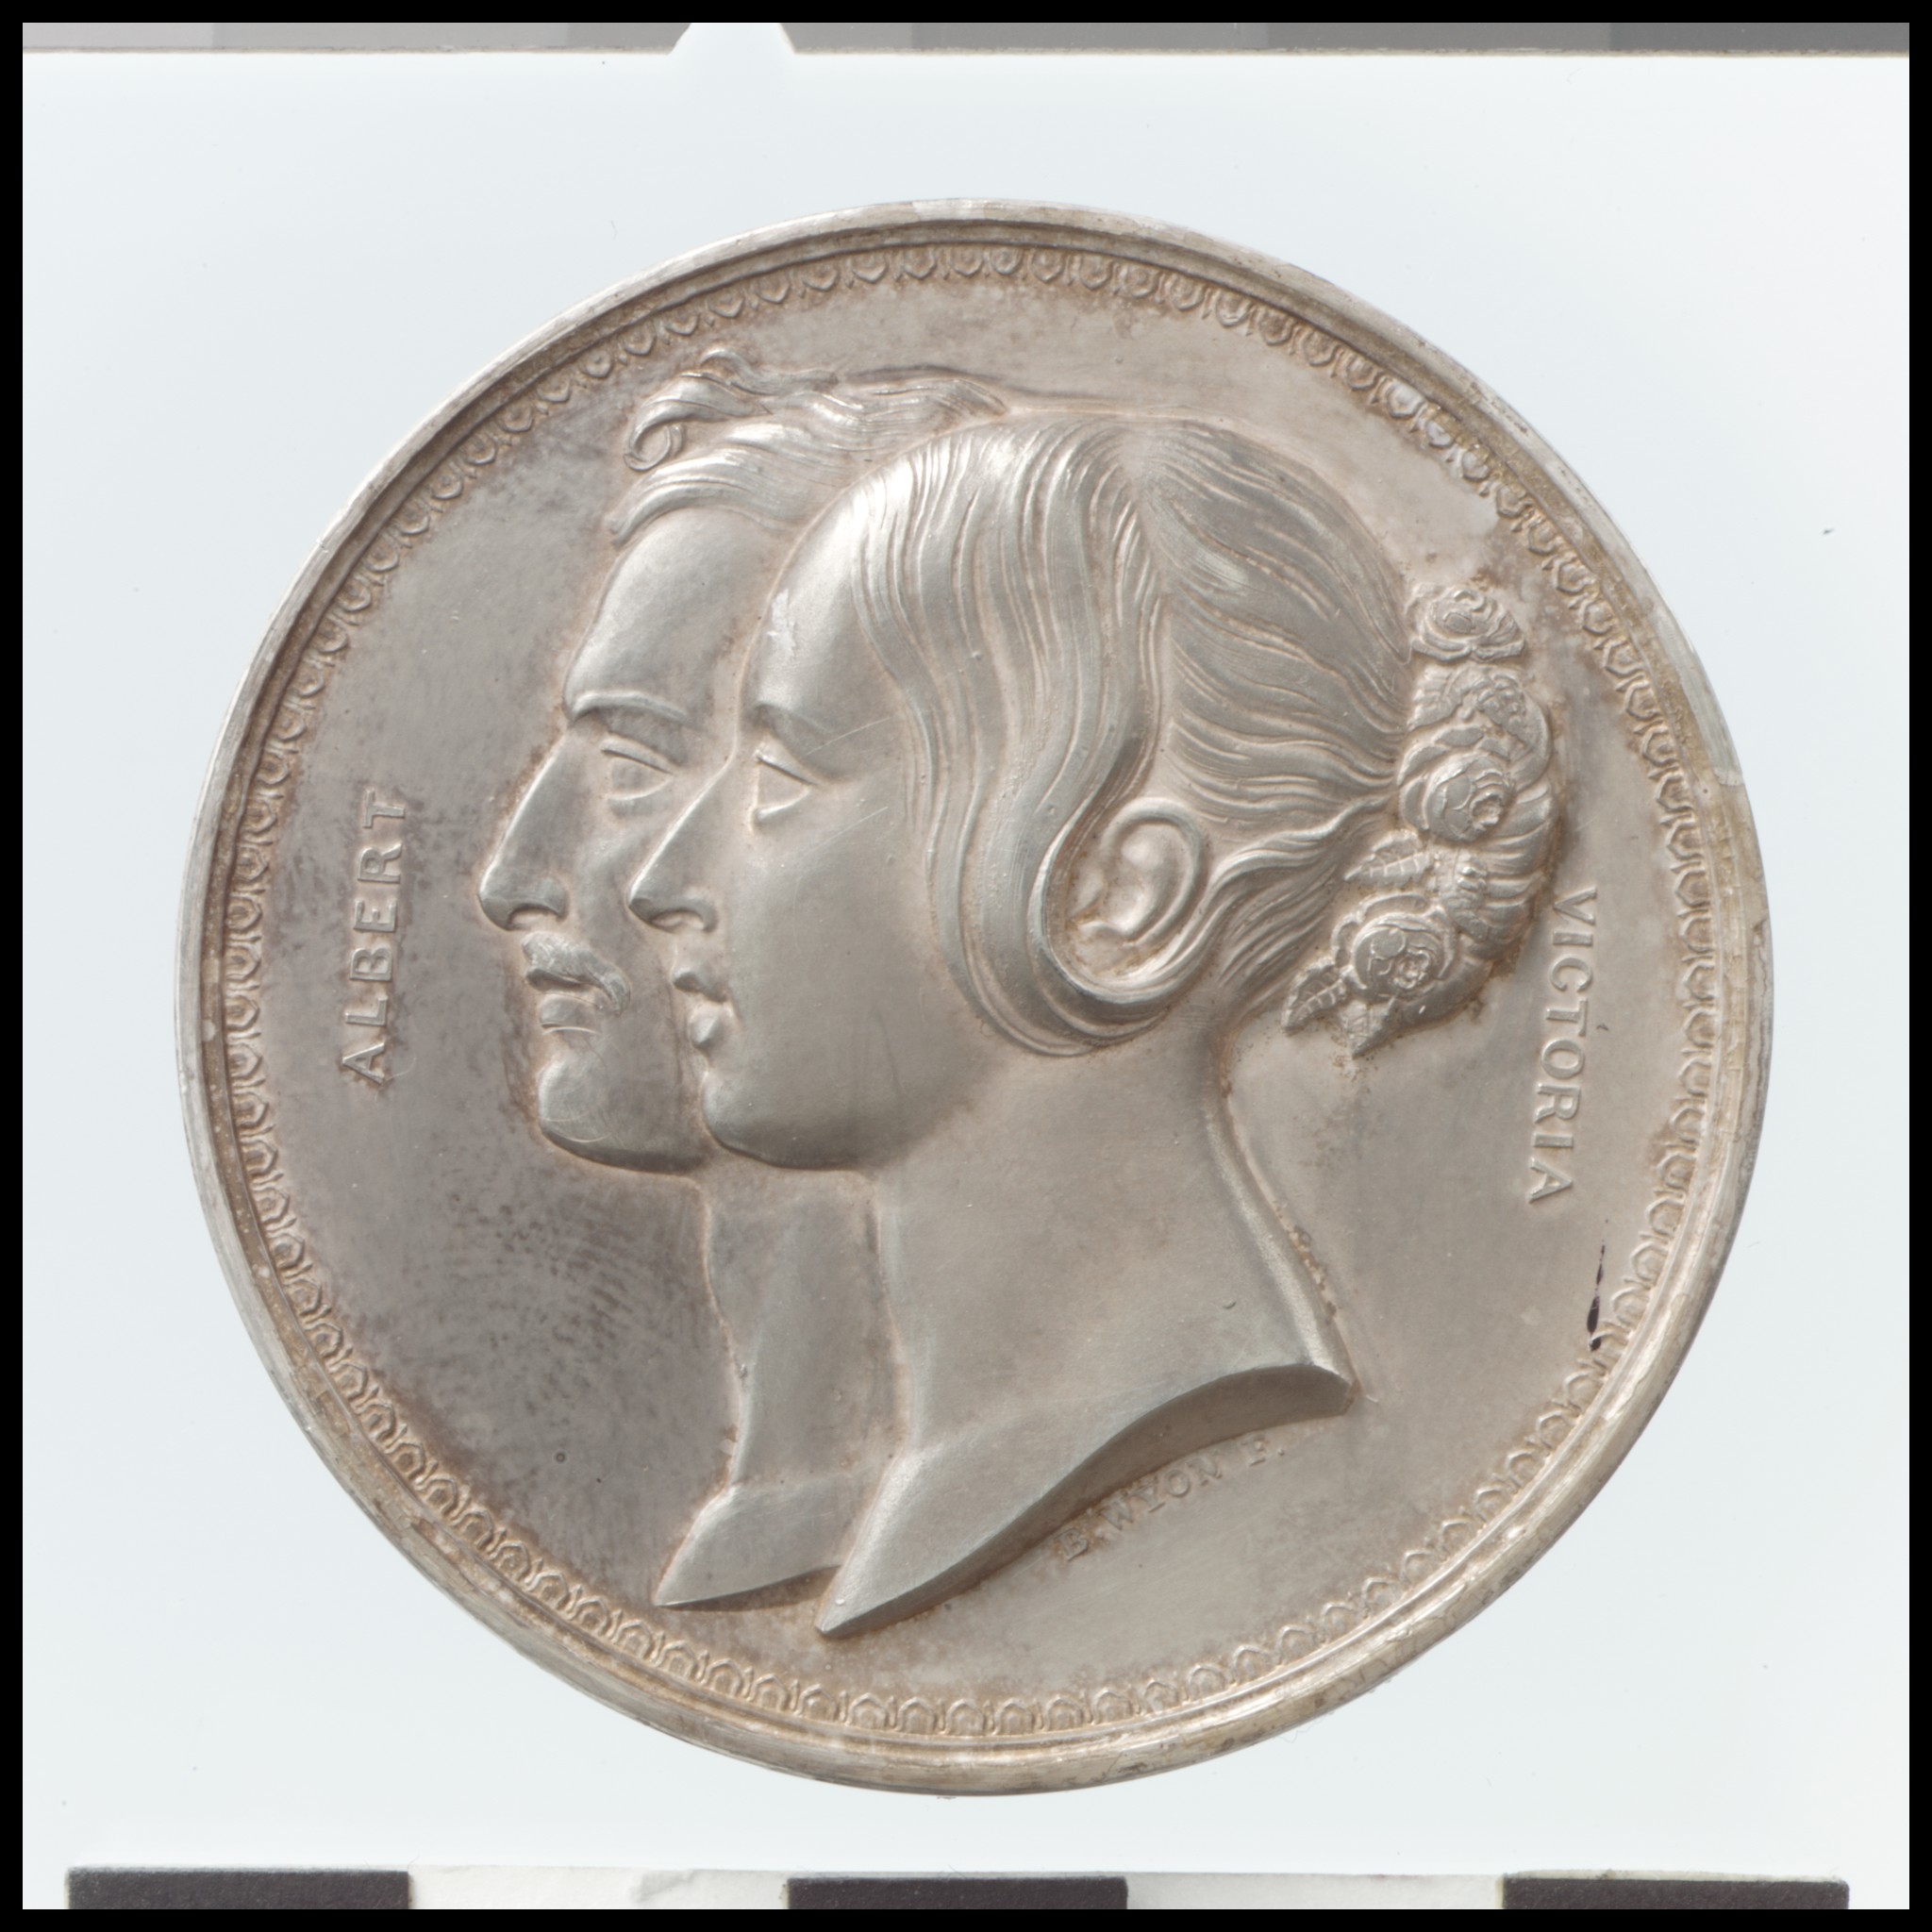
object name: medal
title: Marriage of Victoria and Albert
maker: benjamin wyon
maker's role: maker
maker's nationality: british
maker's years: 1802-1858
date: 1840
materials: silver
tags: princes,profiles,coat of arms